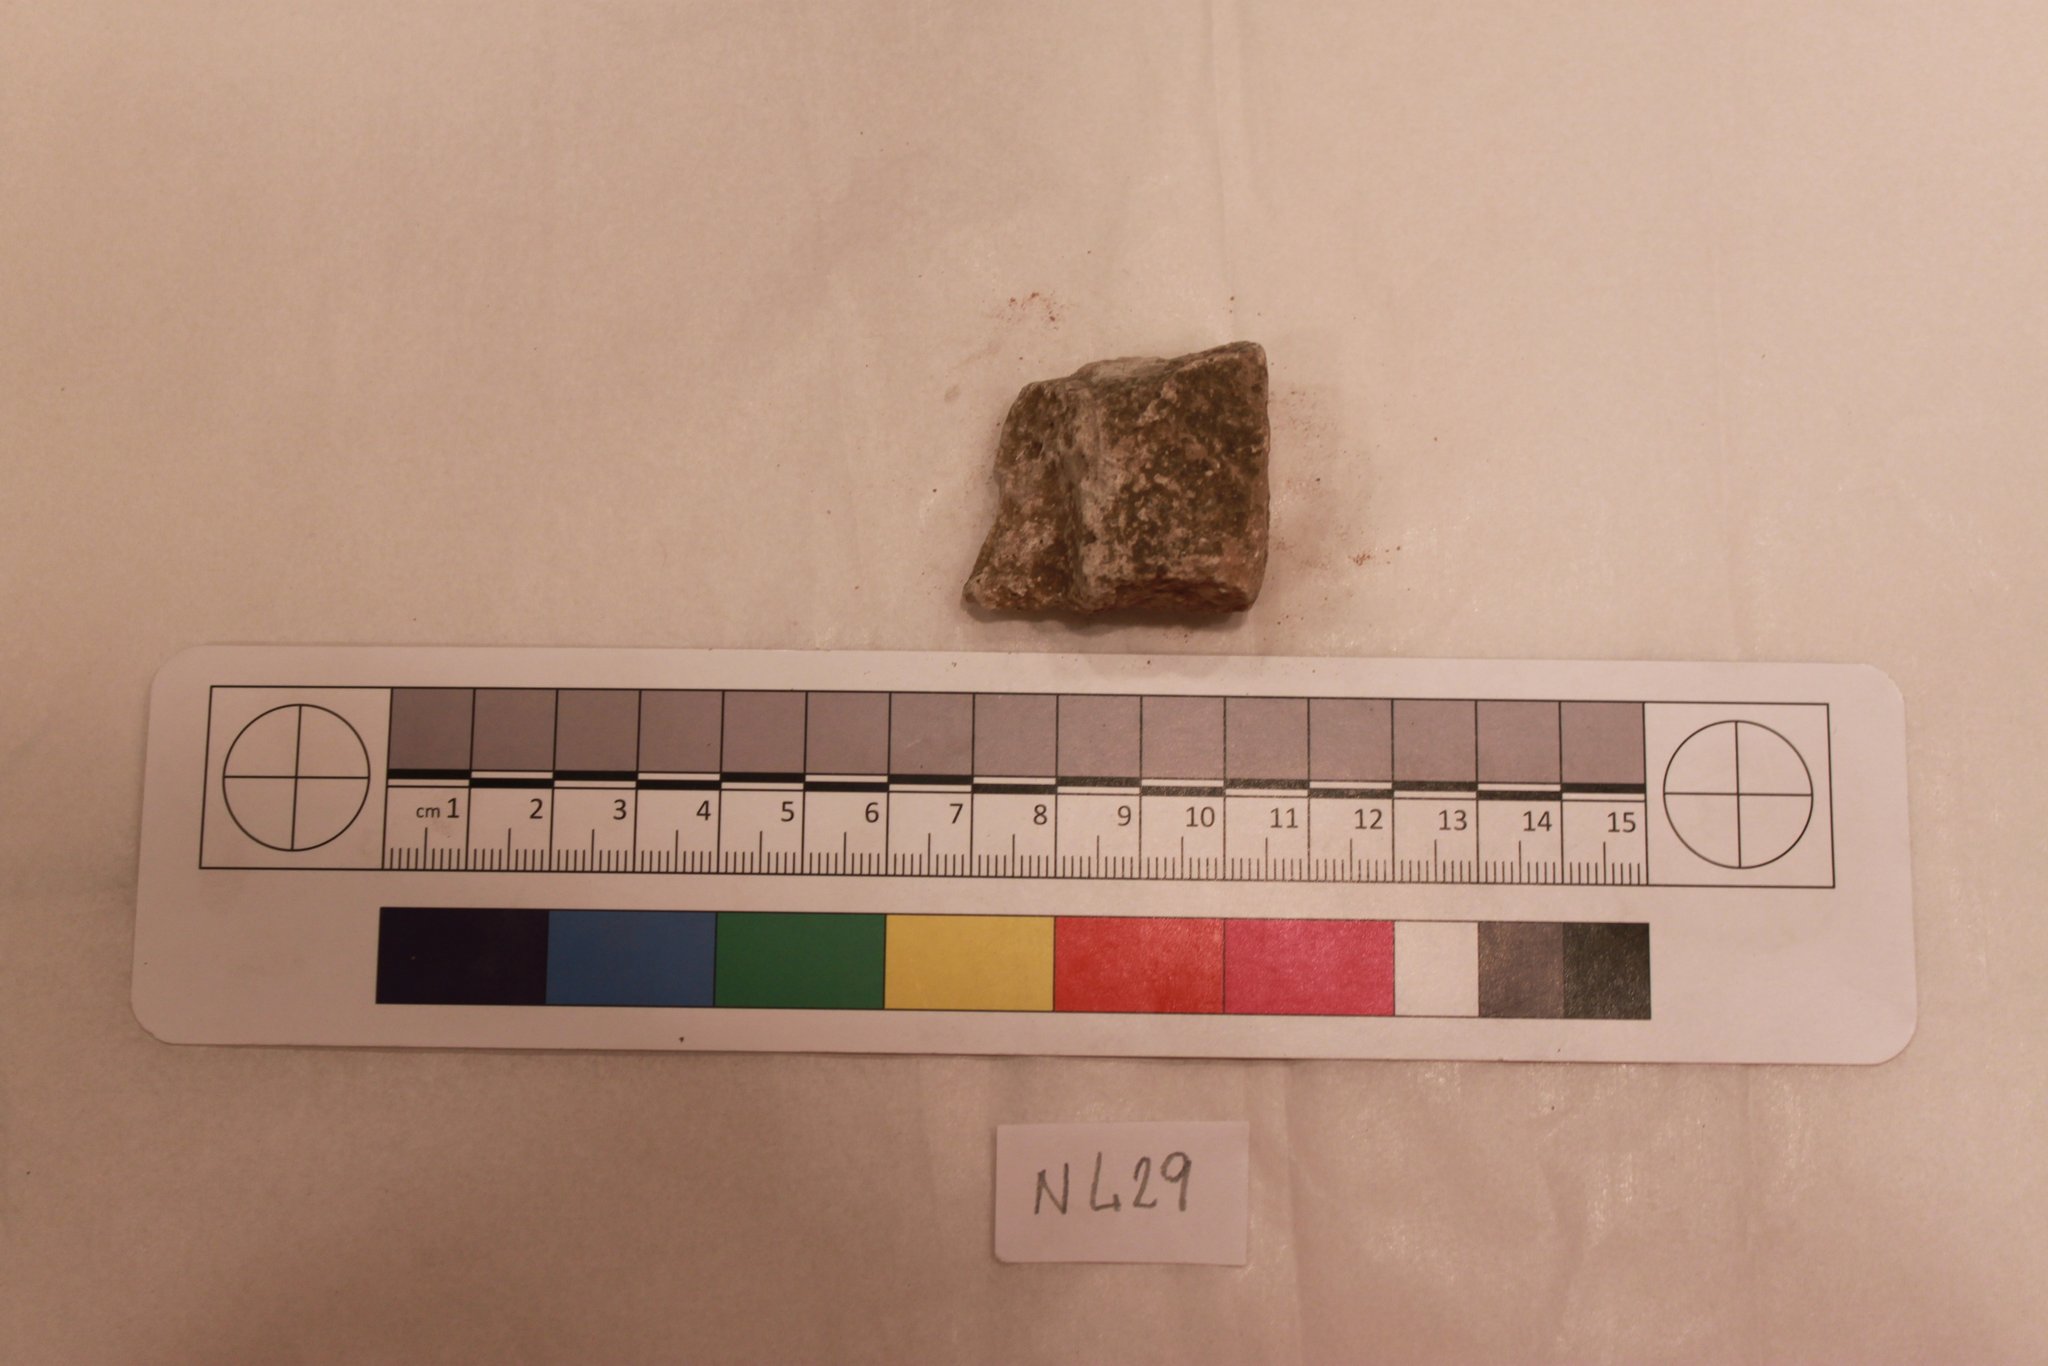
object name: fragment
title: Stucco Fragment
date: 701-1200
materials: plaster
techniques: carving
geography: iran